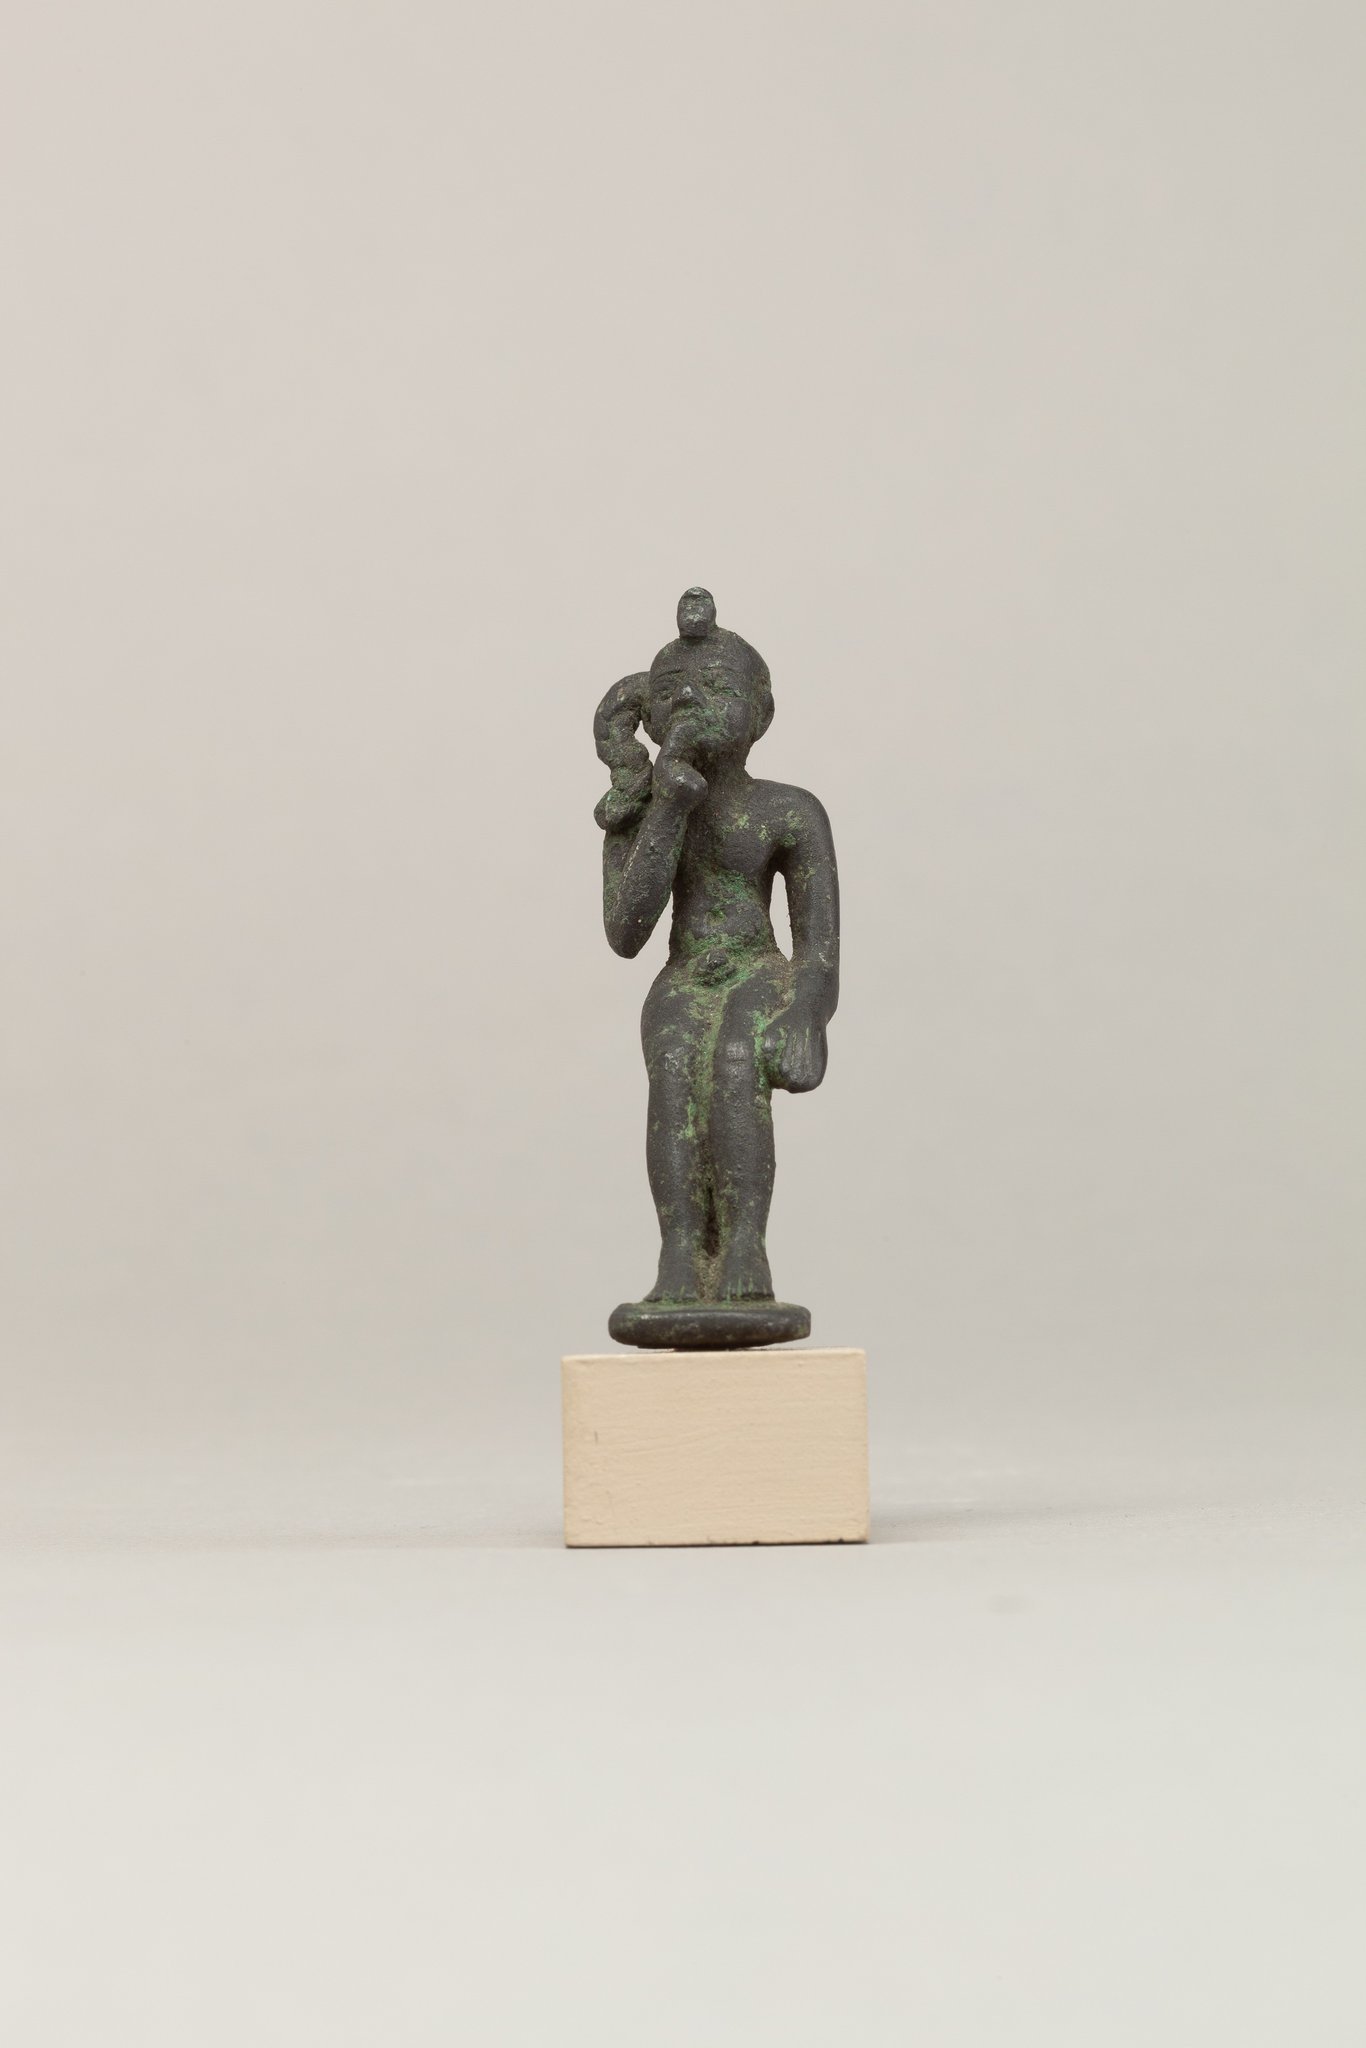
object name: statuette, child god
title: Child God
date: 664-630 BCE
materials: metal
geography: egypt